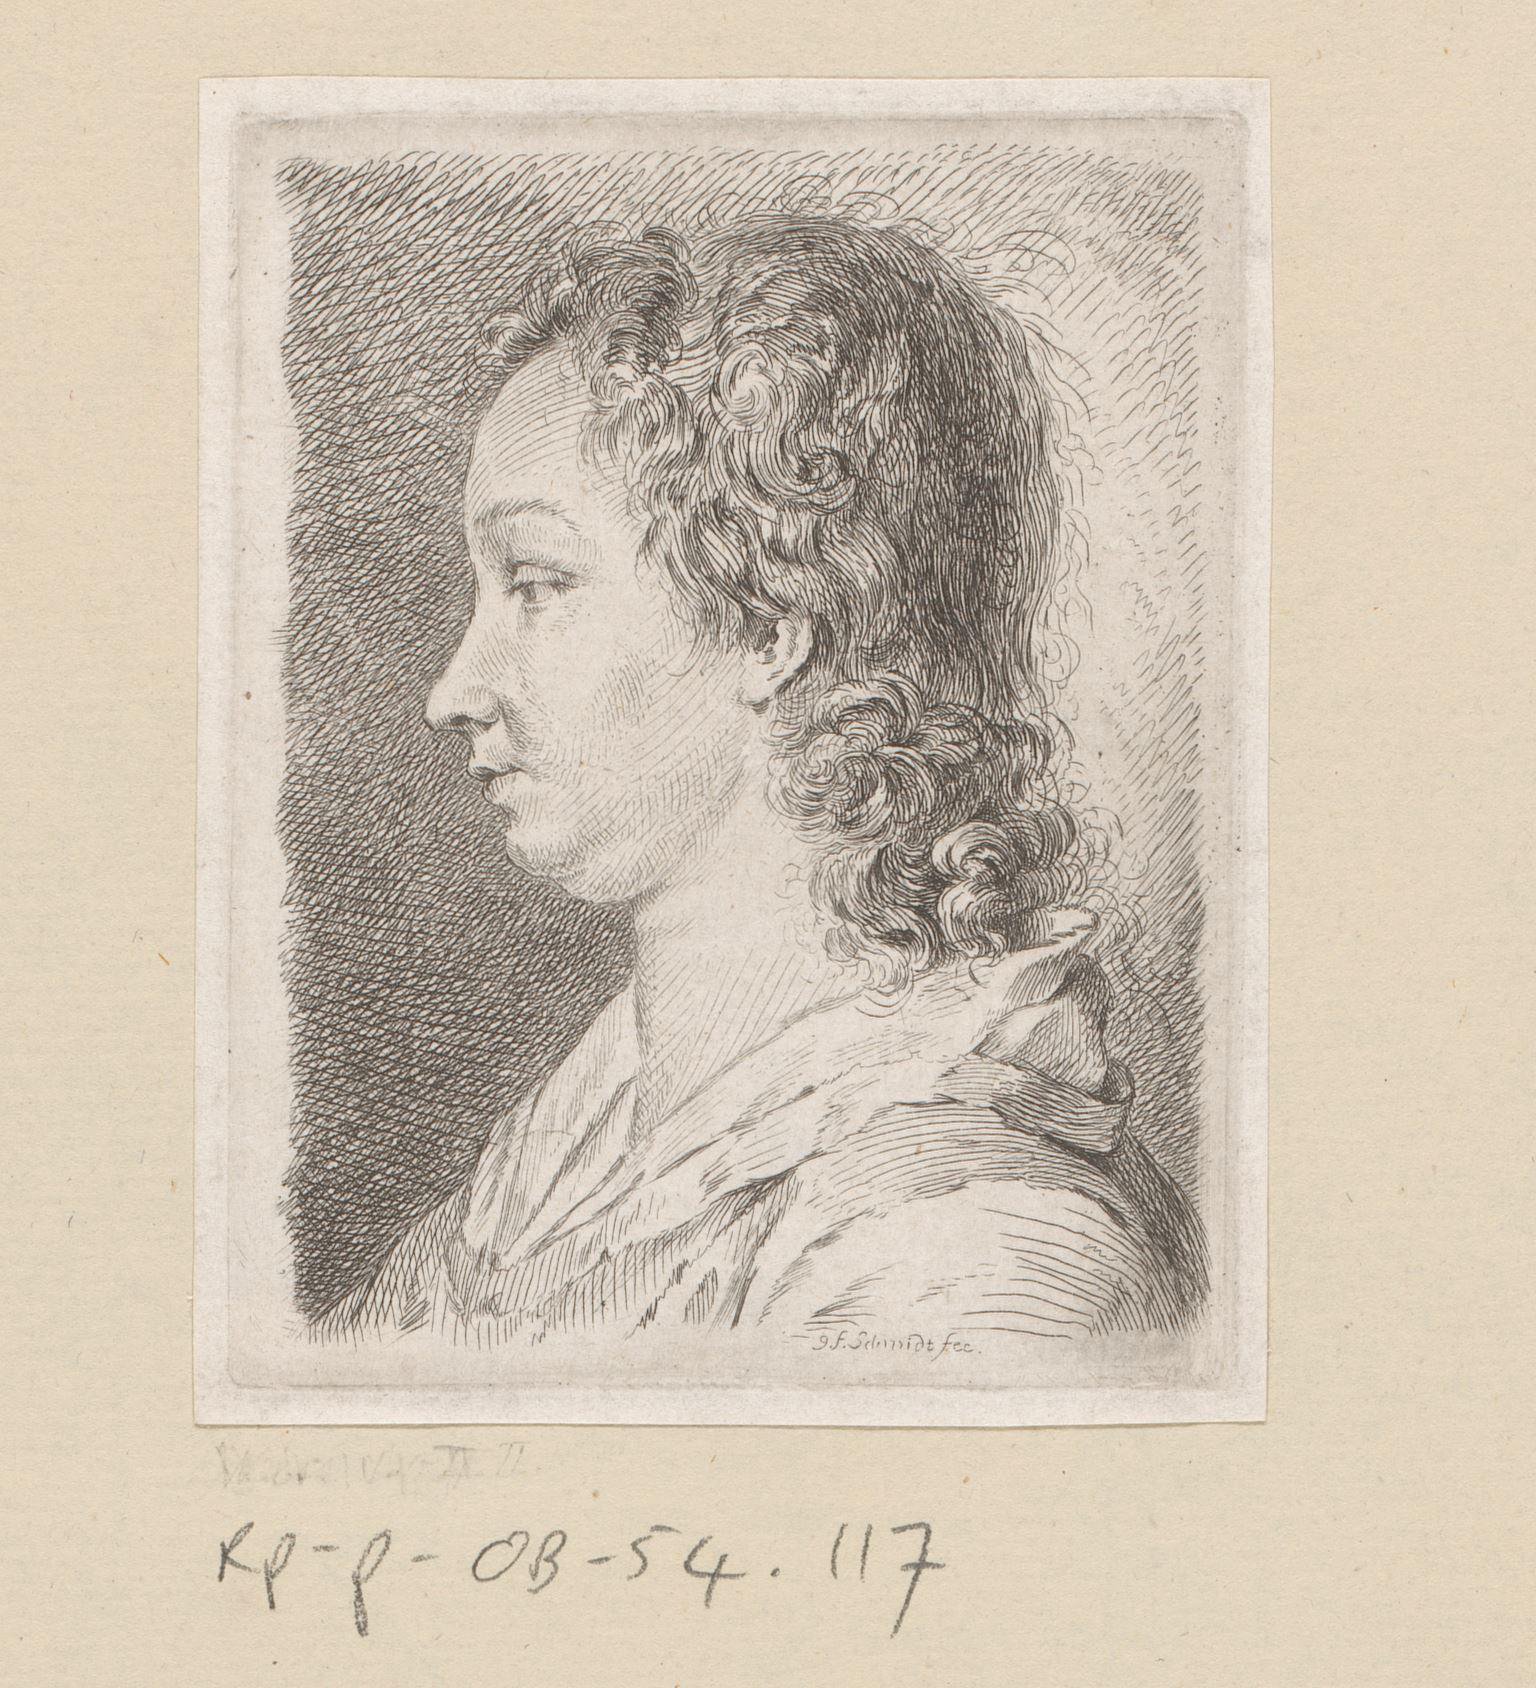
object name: print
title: Portret van Dorothea Louise Schmidt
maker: georg friedrich schmidt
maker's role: draughtsman, print maker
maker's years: 1712-1775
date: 1722-1775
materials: paper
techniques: etching, intaglio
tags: historical persons - bb - woman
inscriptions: collector's mark: Lugt 240